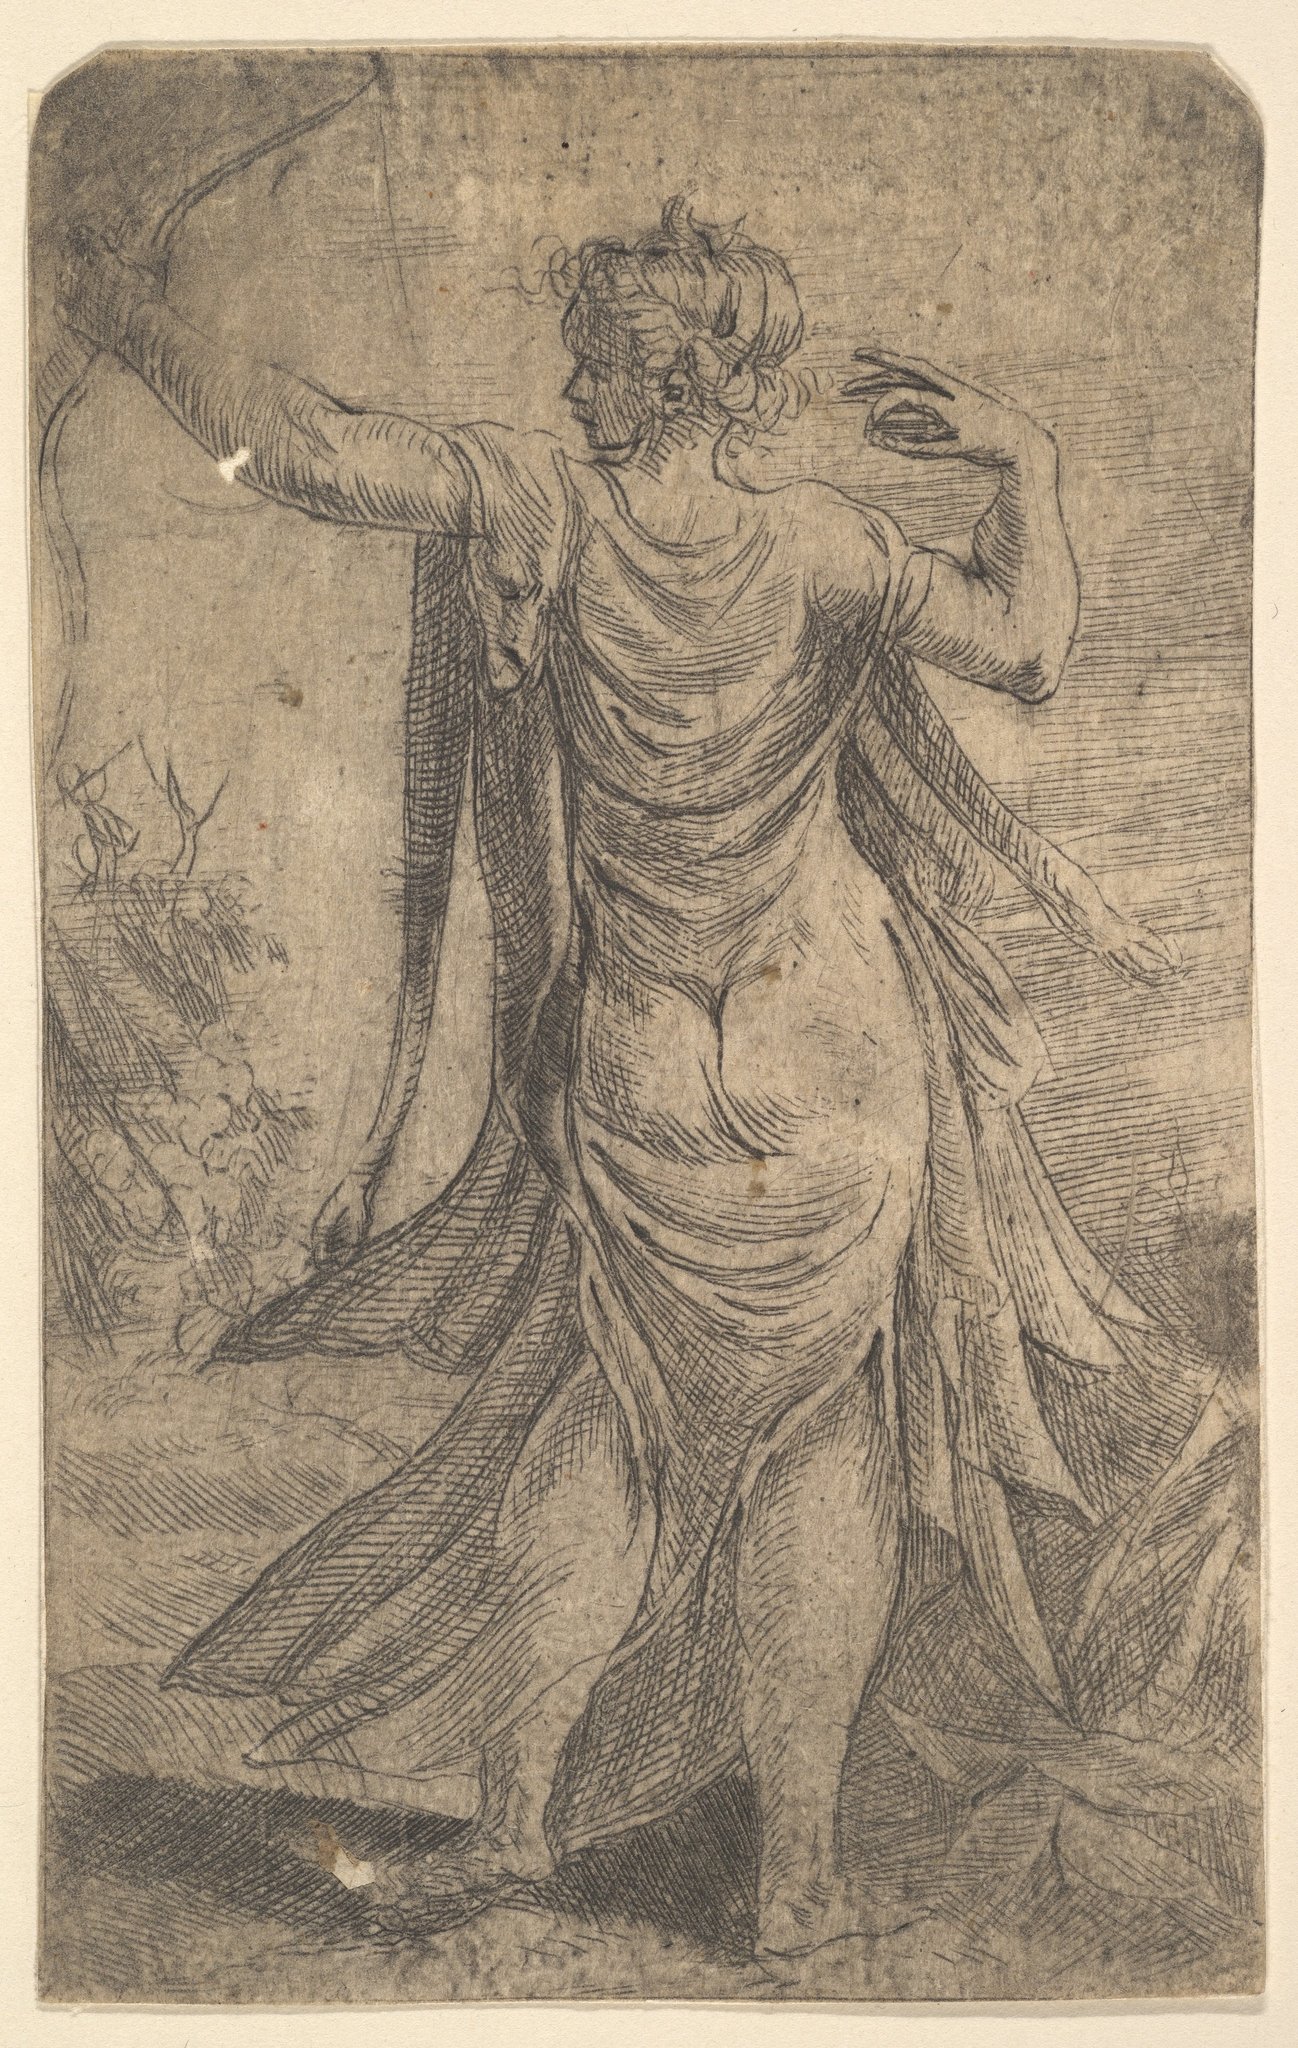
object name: print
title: Diana firing her bow viewed from behind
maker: andrea schiavone (andrea meldola)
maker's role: artist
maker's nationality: italian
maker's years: 1510-1563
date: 1538-1540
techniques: etching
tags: bow and arrow,diana